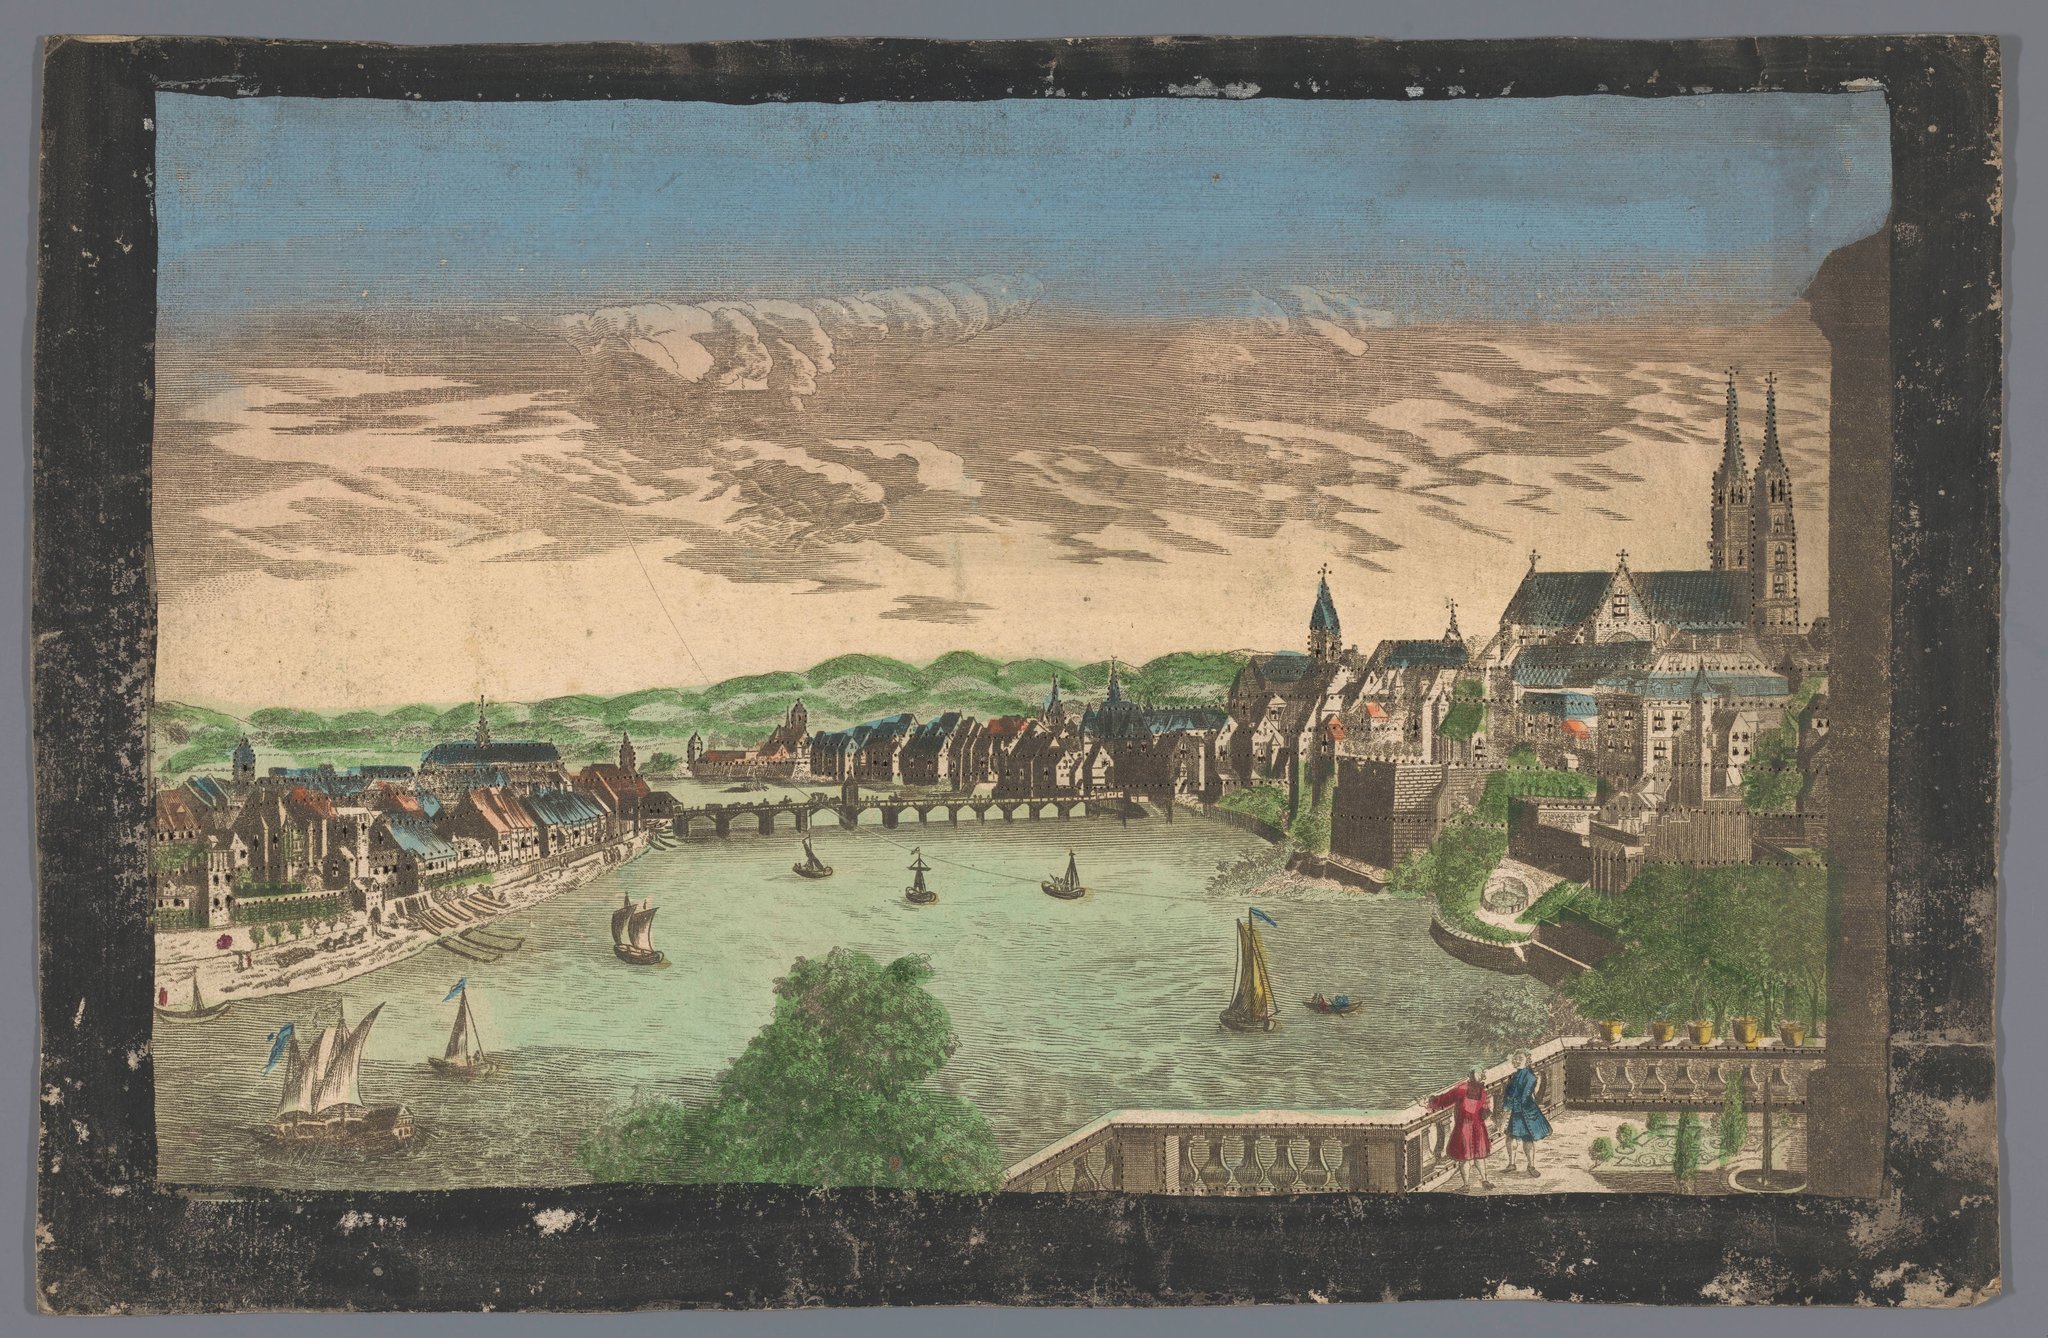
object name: opticaprent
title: Gezicht op de stad Bazel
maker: Anonymous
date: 1700-1799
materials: cardboard, paint, paper, watercolor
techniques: brush, cutting, etching, perforating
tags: bridge in city across river, canal, etc. (+ city(-scape) with figures, staffage), sailing-ship, sailing-boat, church (exterior), city-view in general; 'veduta' (+ city(-scape) with figures, staffage)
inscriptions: collector's mark: Lugt 2233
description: In het midden een brug over de rivier de Rijn. Rechts de Munster van Bazel.